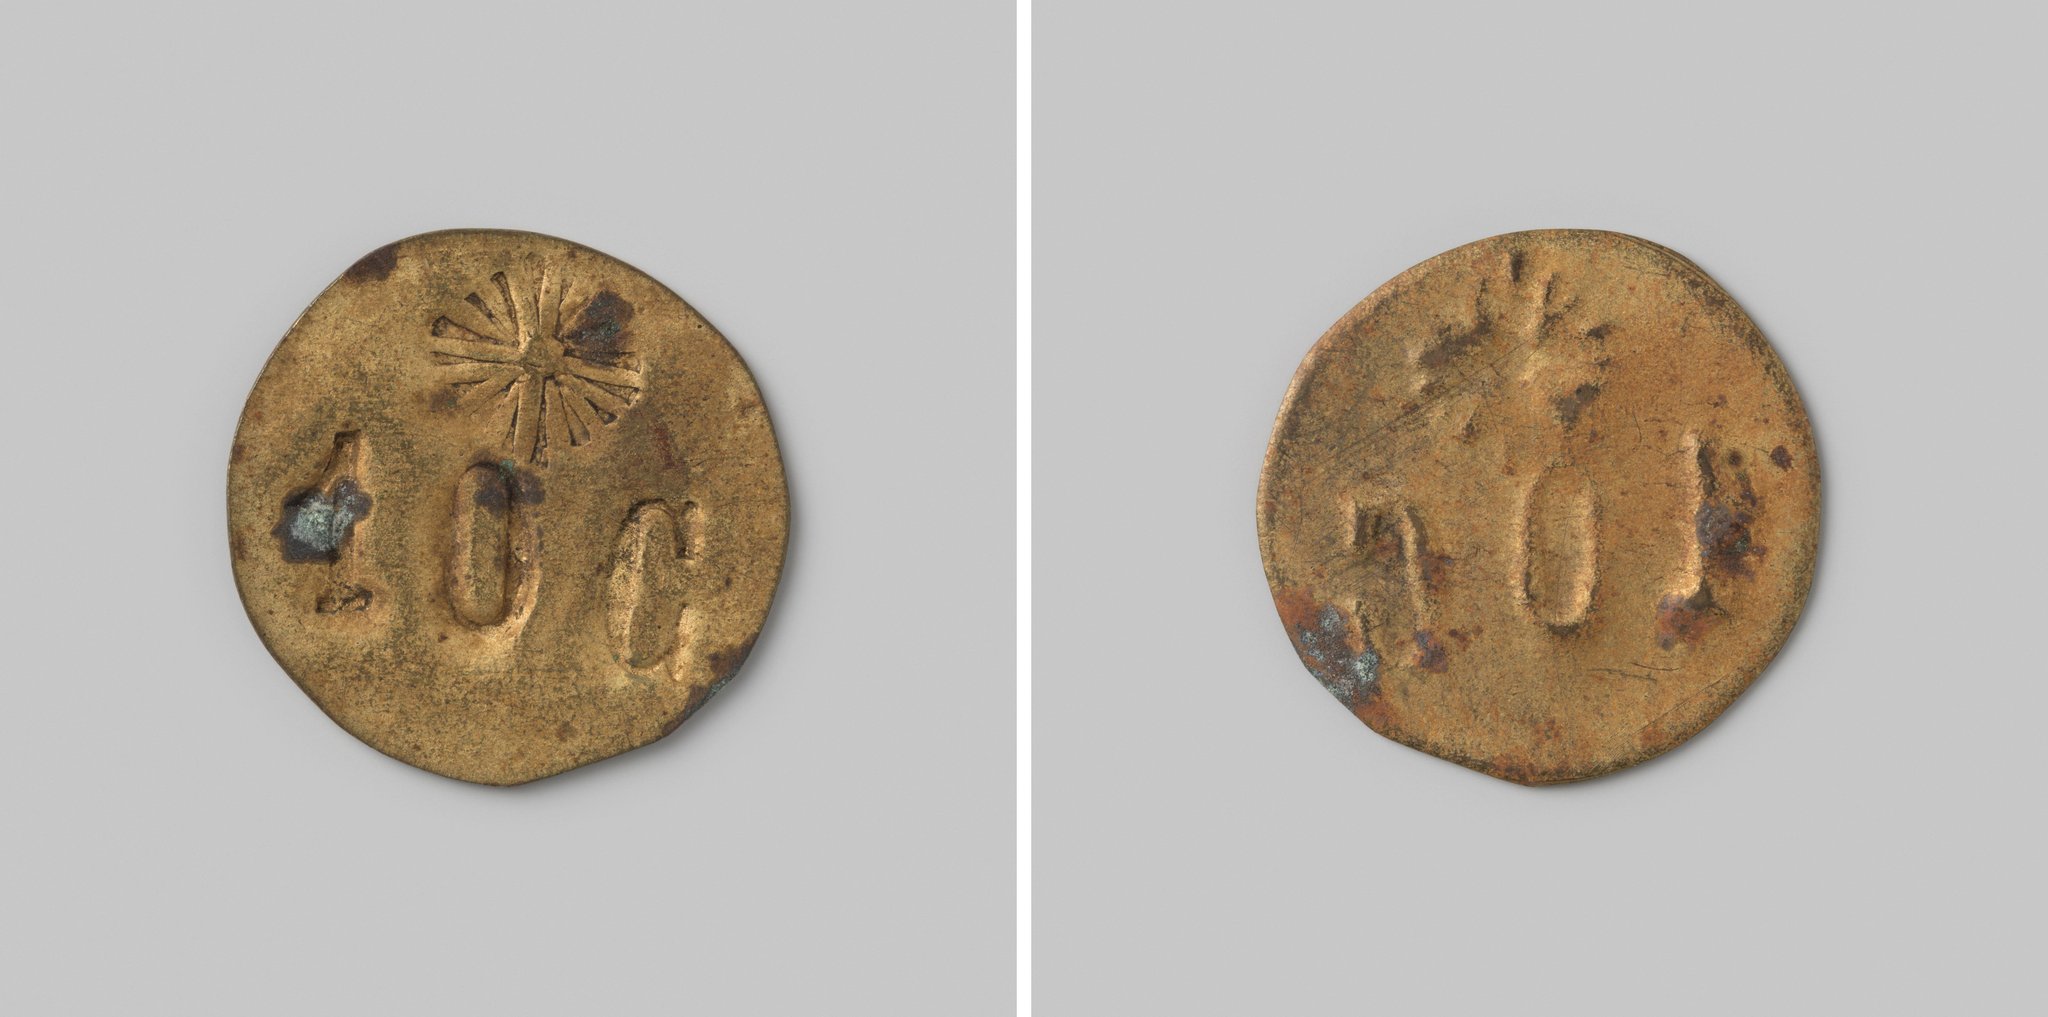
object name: history medal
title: Betaalpenning van 10 cents van de Coöperatieve Winkelvereeniging Eendracht Maakt Magt te Hilversum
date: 1875-1900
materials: brass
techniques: printing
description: Rond messing plaatje met inwaartse instempelingen (ster) / 10 C